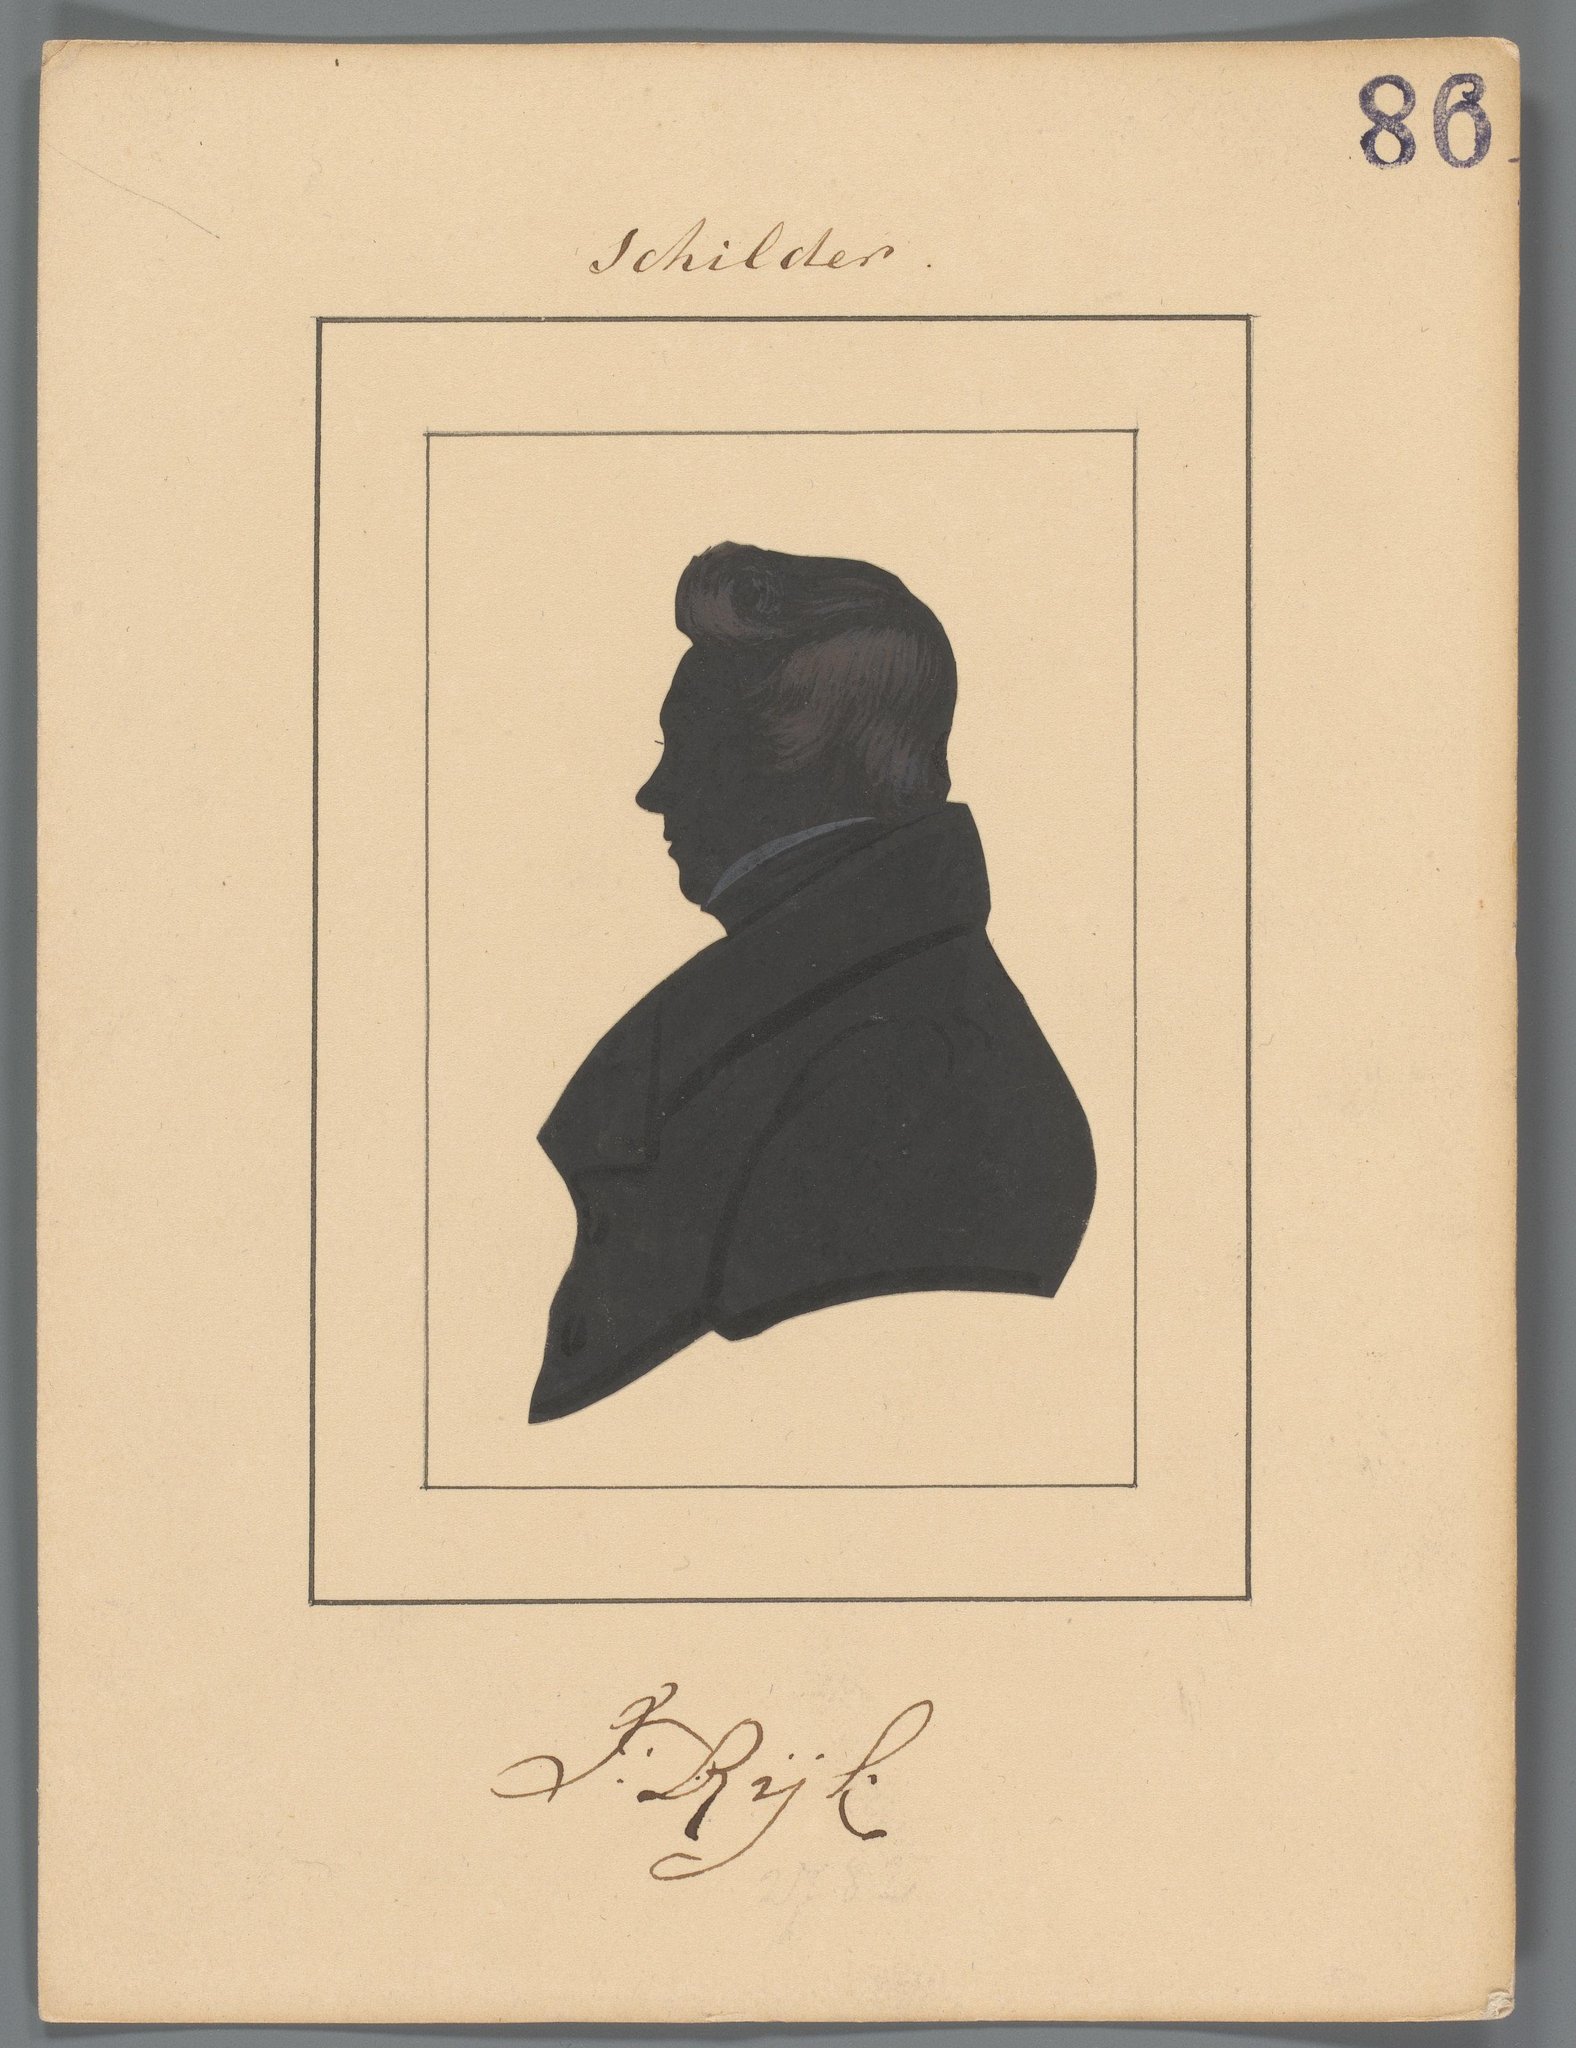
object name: silhouette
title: Silhouetportret van James de Rijk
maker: elisabeth alida haanen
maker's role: draughtsman, print maker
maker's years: 1809-1845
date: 1819-1845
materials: ink, paint, paper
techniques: brush, snipping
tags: james de rijk, historical persons, portrait, self-portrait of painter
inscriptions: inscription: ‘J: Rijk’, number: ‘13955’, inscription: ‘Schilder’, inscription: ‘D. 1728’, number: ‘86’, collector's mark: ‘Ex-libris van Beresteyn’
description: Met onder het portret de handtekening van de geportretteerde.